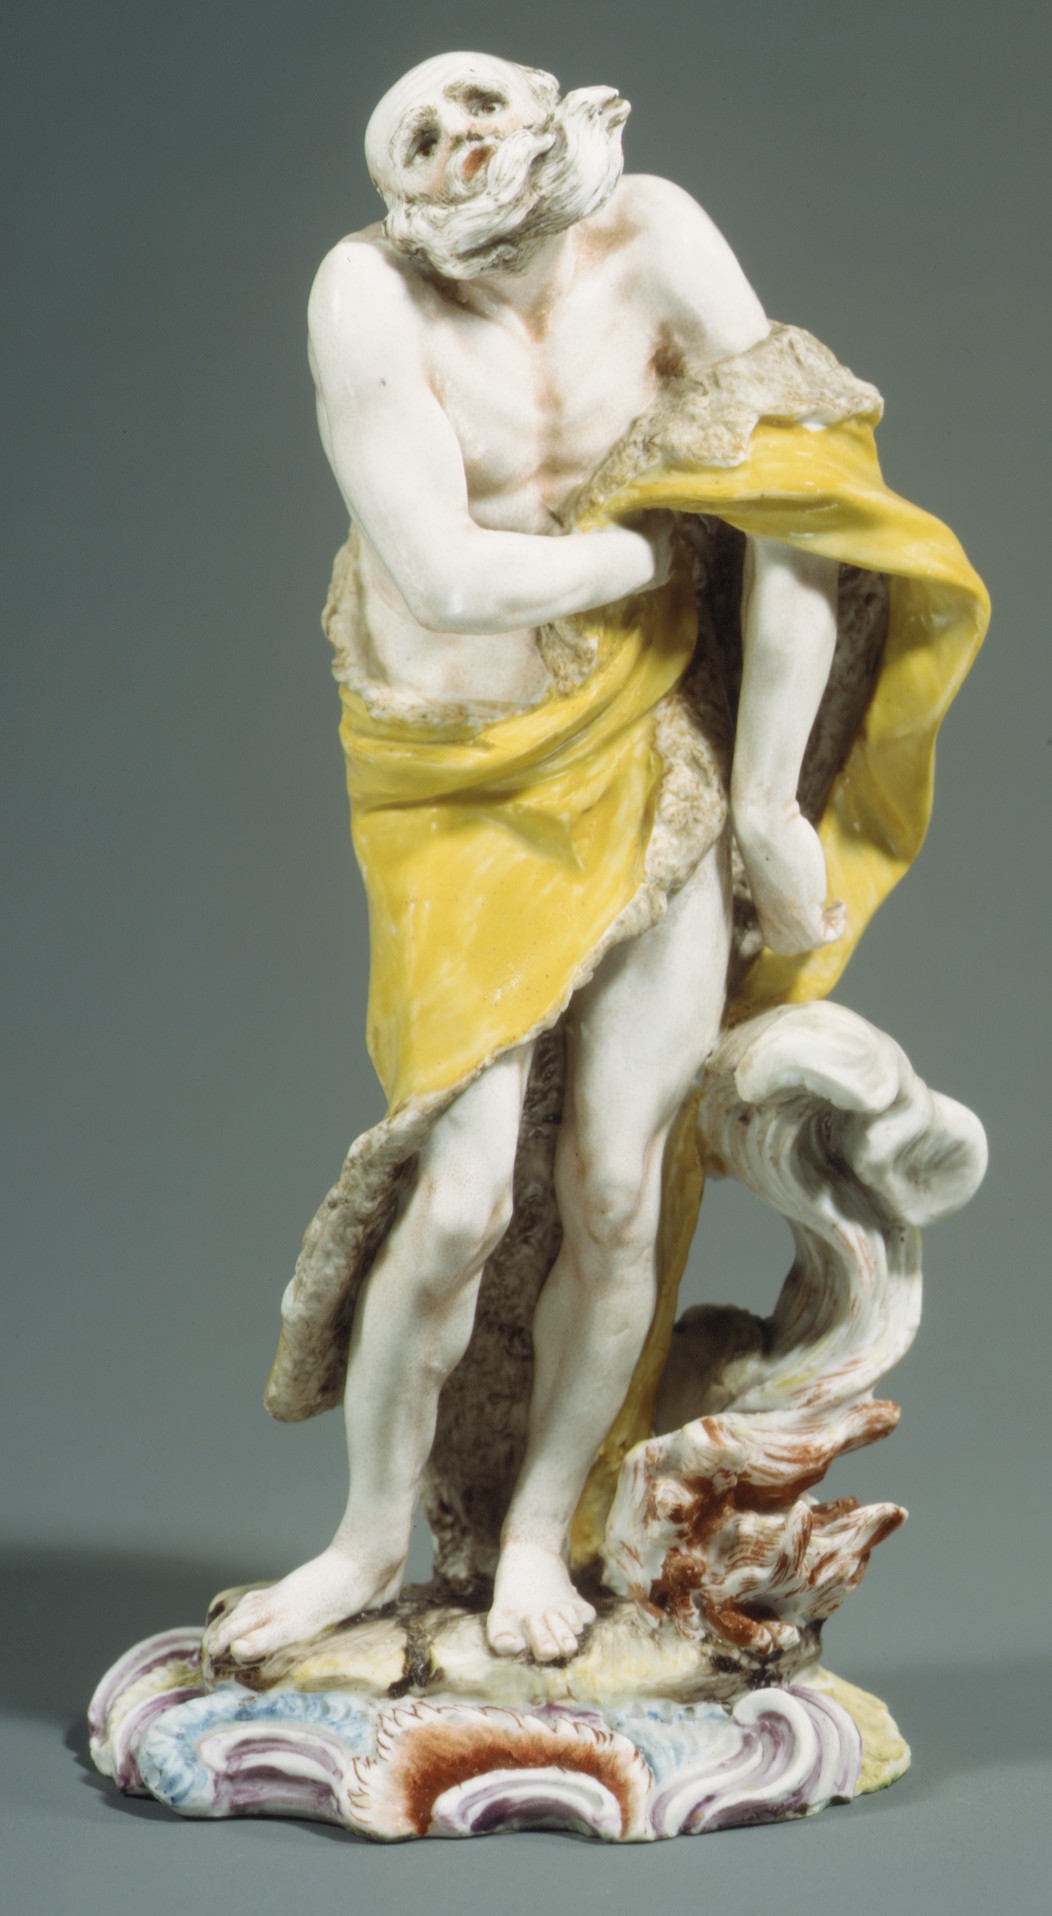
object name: figure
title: Winter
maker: doccia porcelain manufactory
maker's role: manufactory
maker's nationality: italian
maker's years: 1737-1896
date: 1760-1770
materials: hard paste porcelain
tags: men